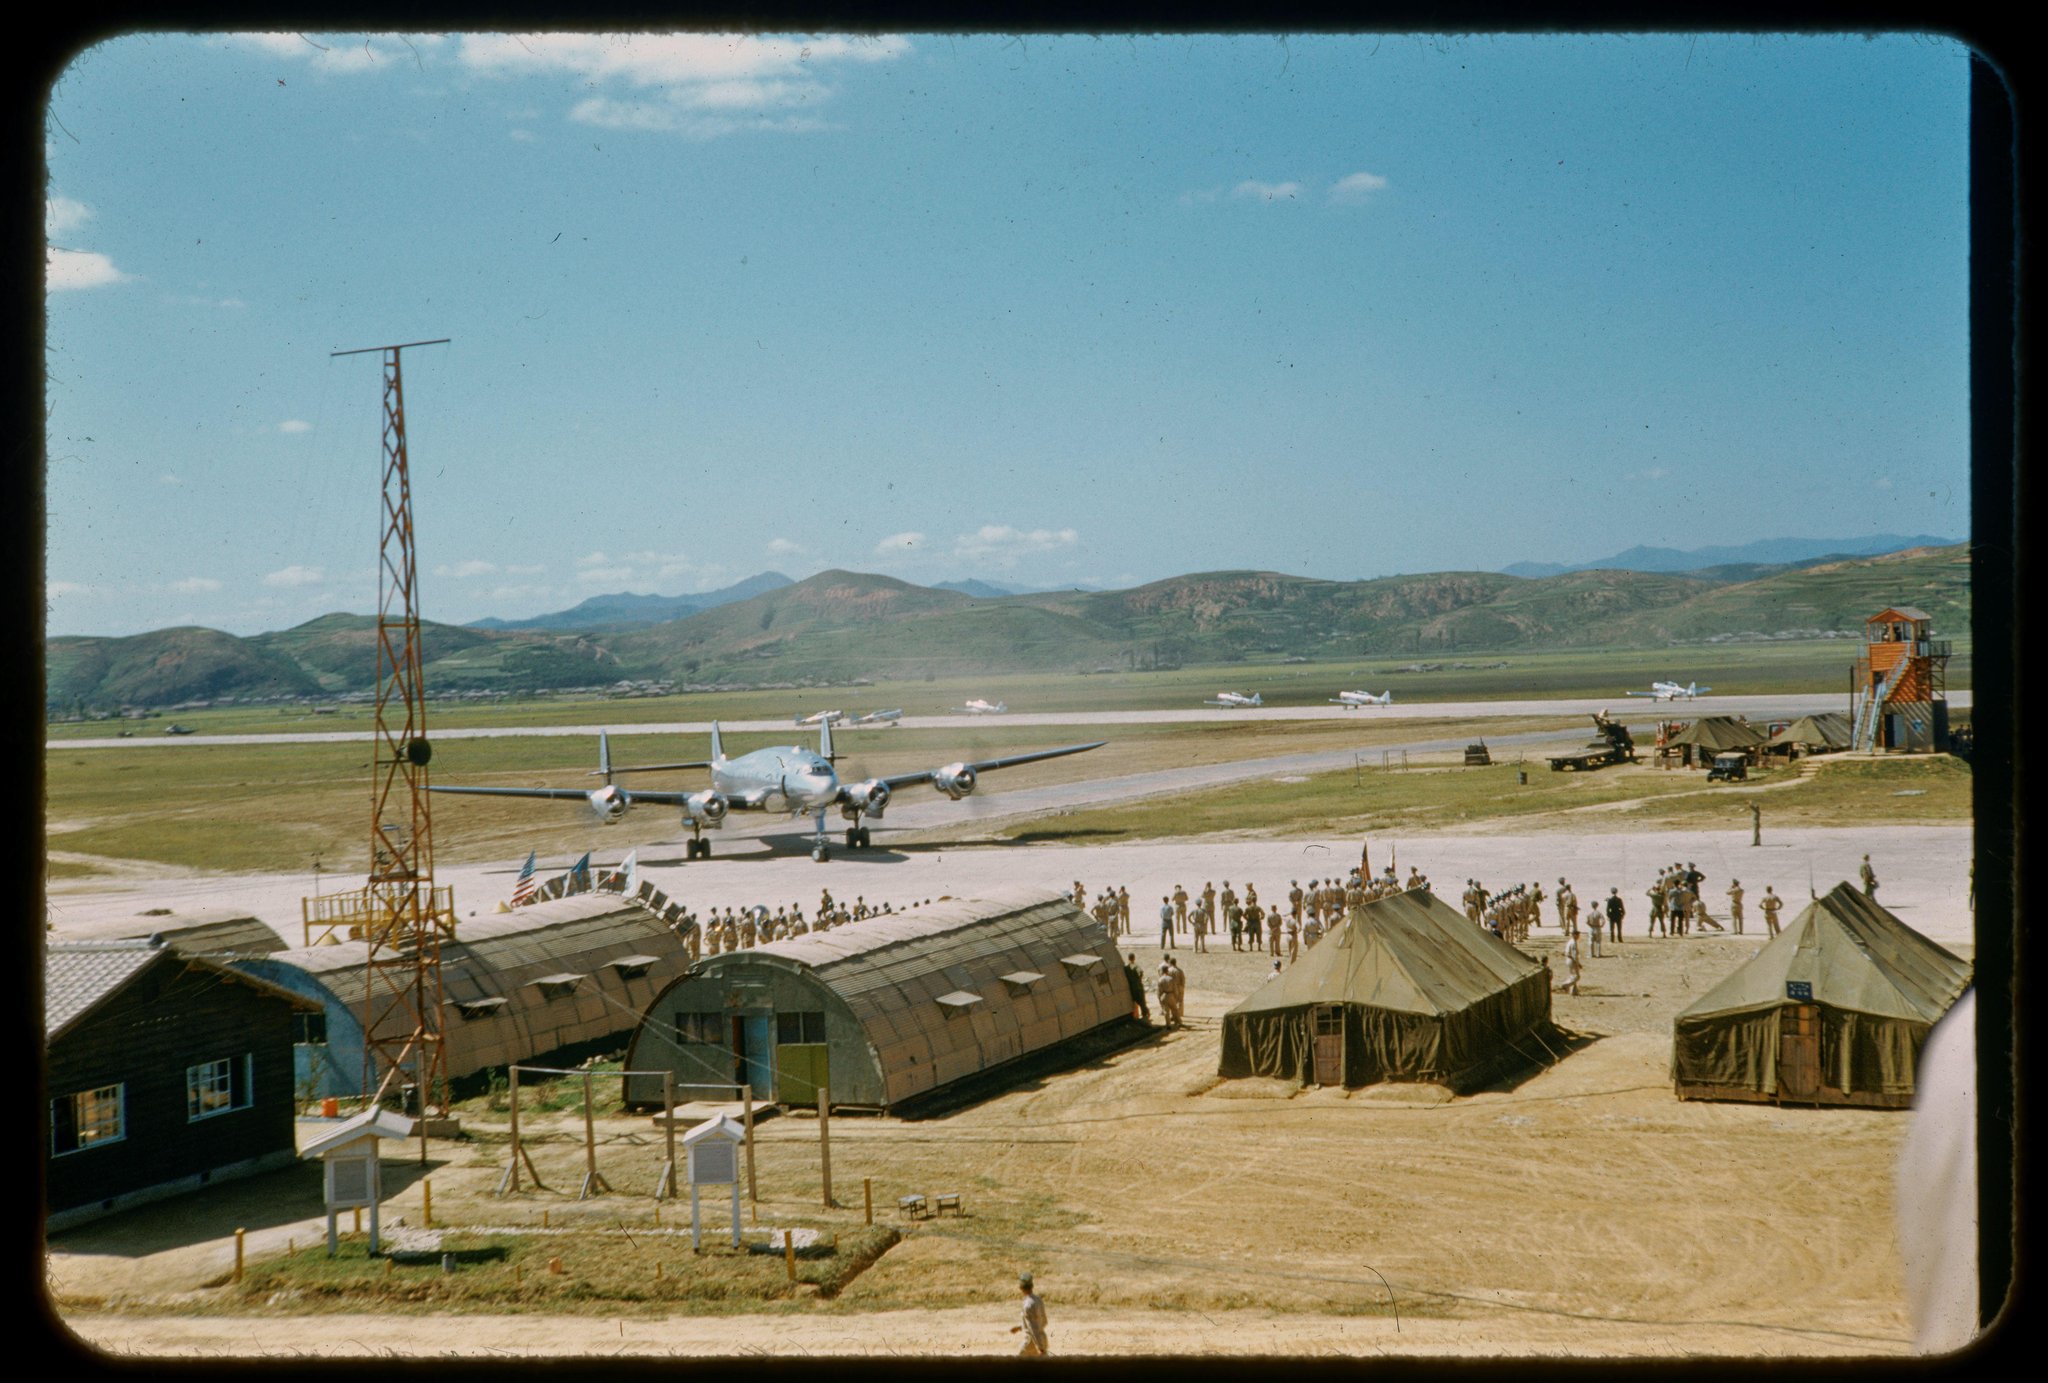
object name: color slide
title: Oorlog in Korea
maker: david ketel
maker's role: diplomaat, sinoloog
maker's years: 1913-2008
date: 1909-1952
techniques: slide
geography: korea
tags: united nations